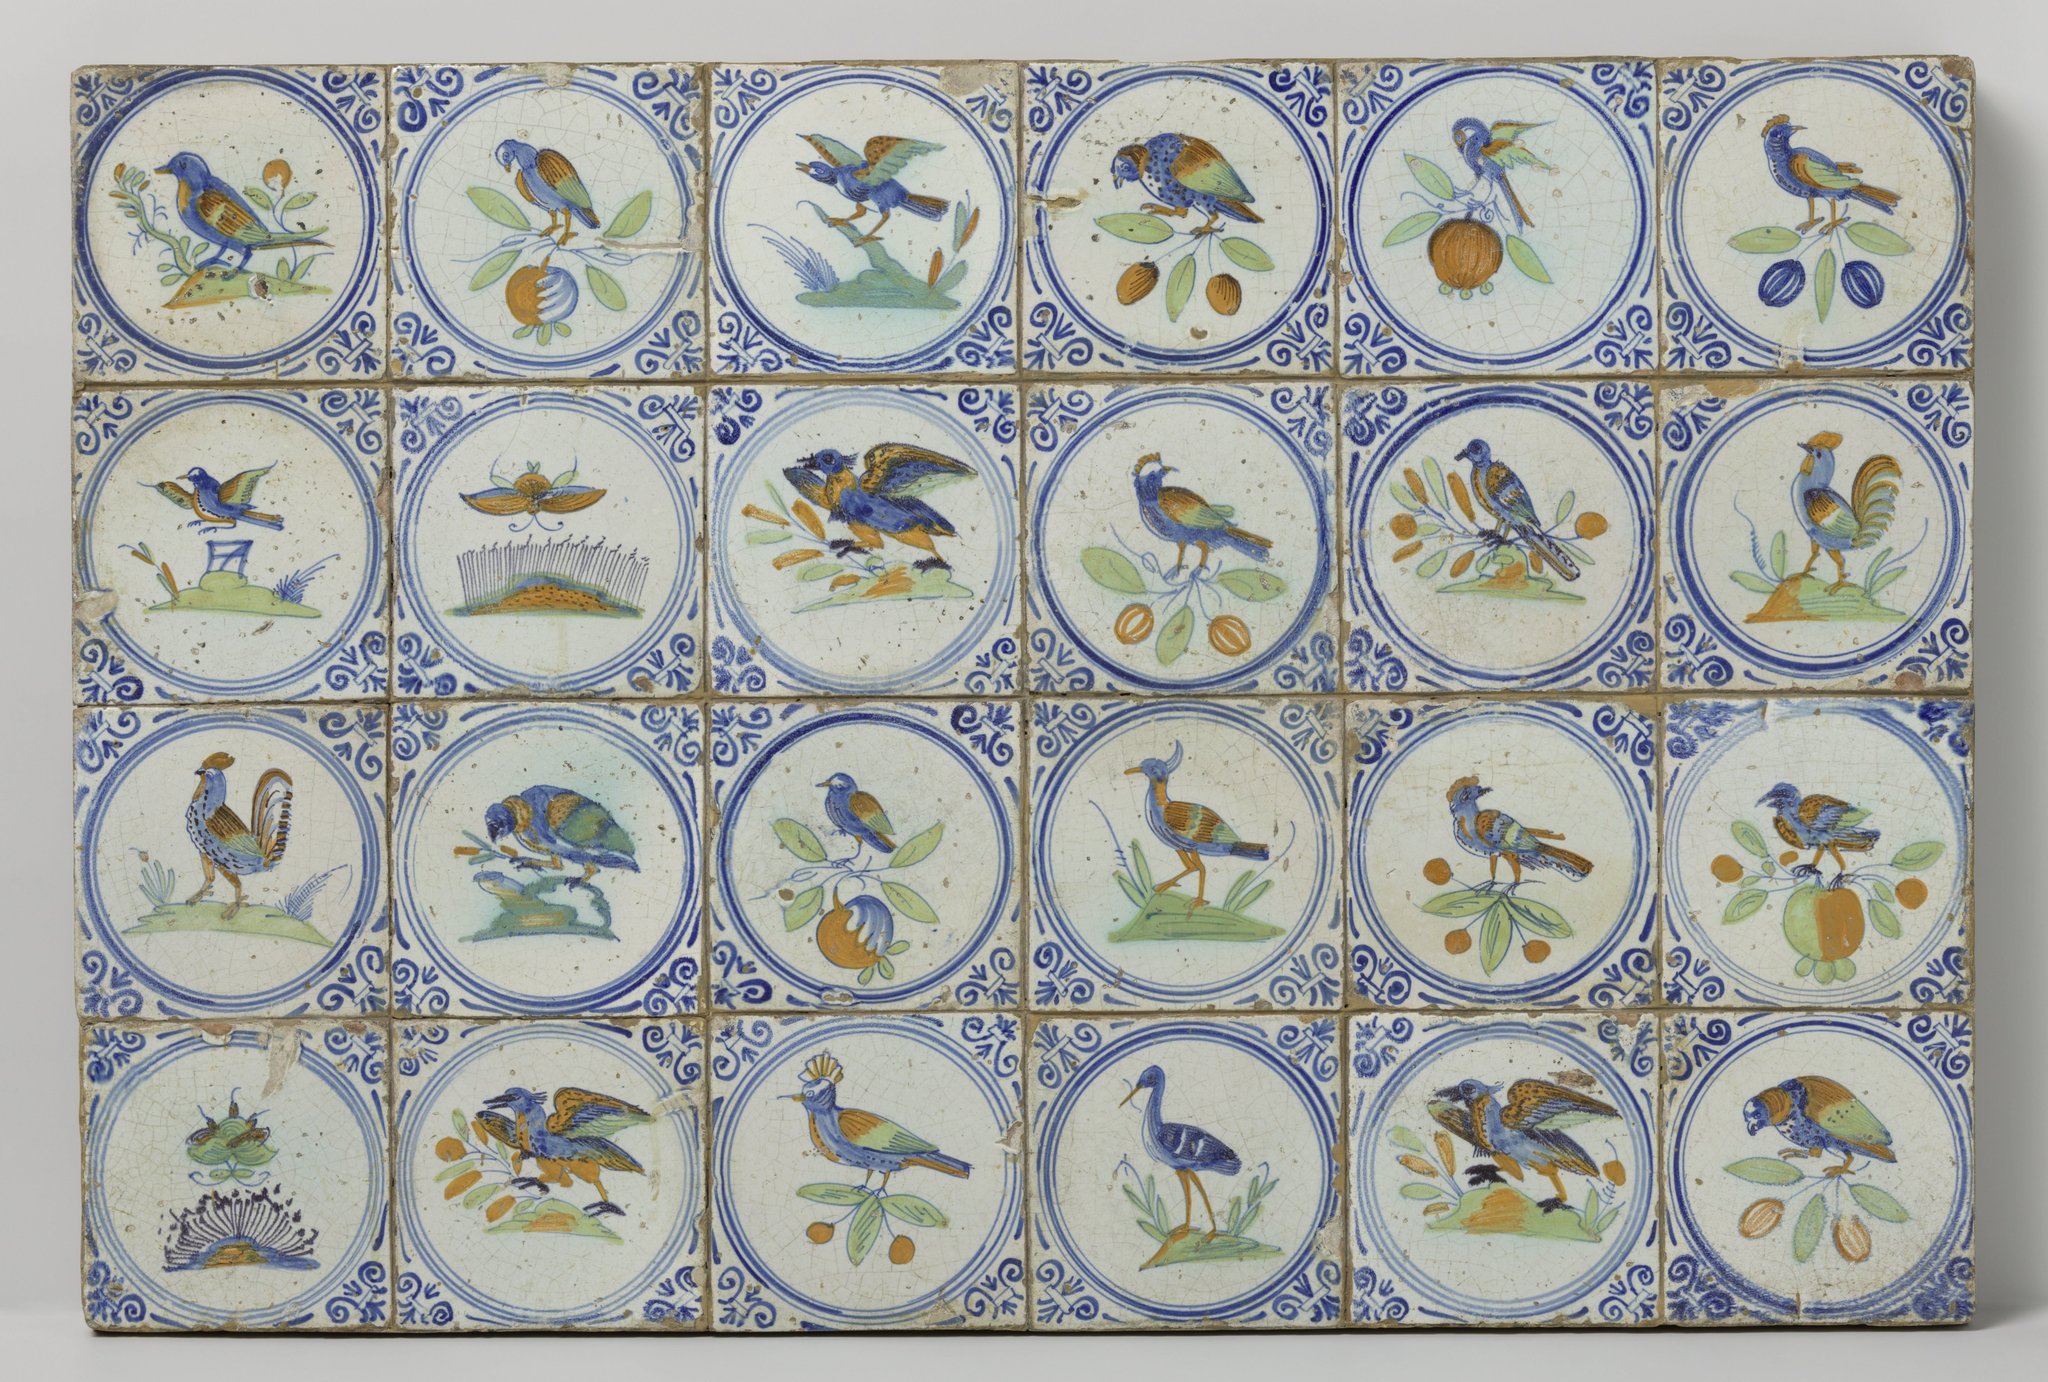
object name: tegelveld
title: Veld van vierentwintig tegels met vogels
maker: Anonymous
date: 1640-1670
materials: earthenware, glaze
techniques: maiolica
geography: netherlands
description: Veld van vierentwintig tegels (4 x 6) elk met een veelkleurig (blauw, groen, geel, oranje en paars) geschilderde vogel op een grond of tak binnen een cirkel met in de hoeken een ossenkop.